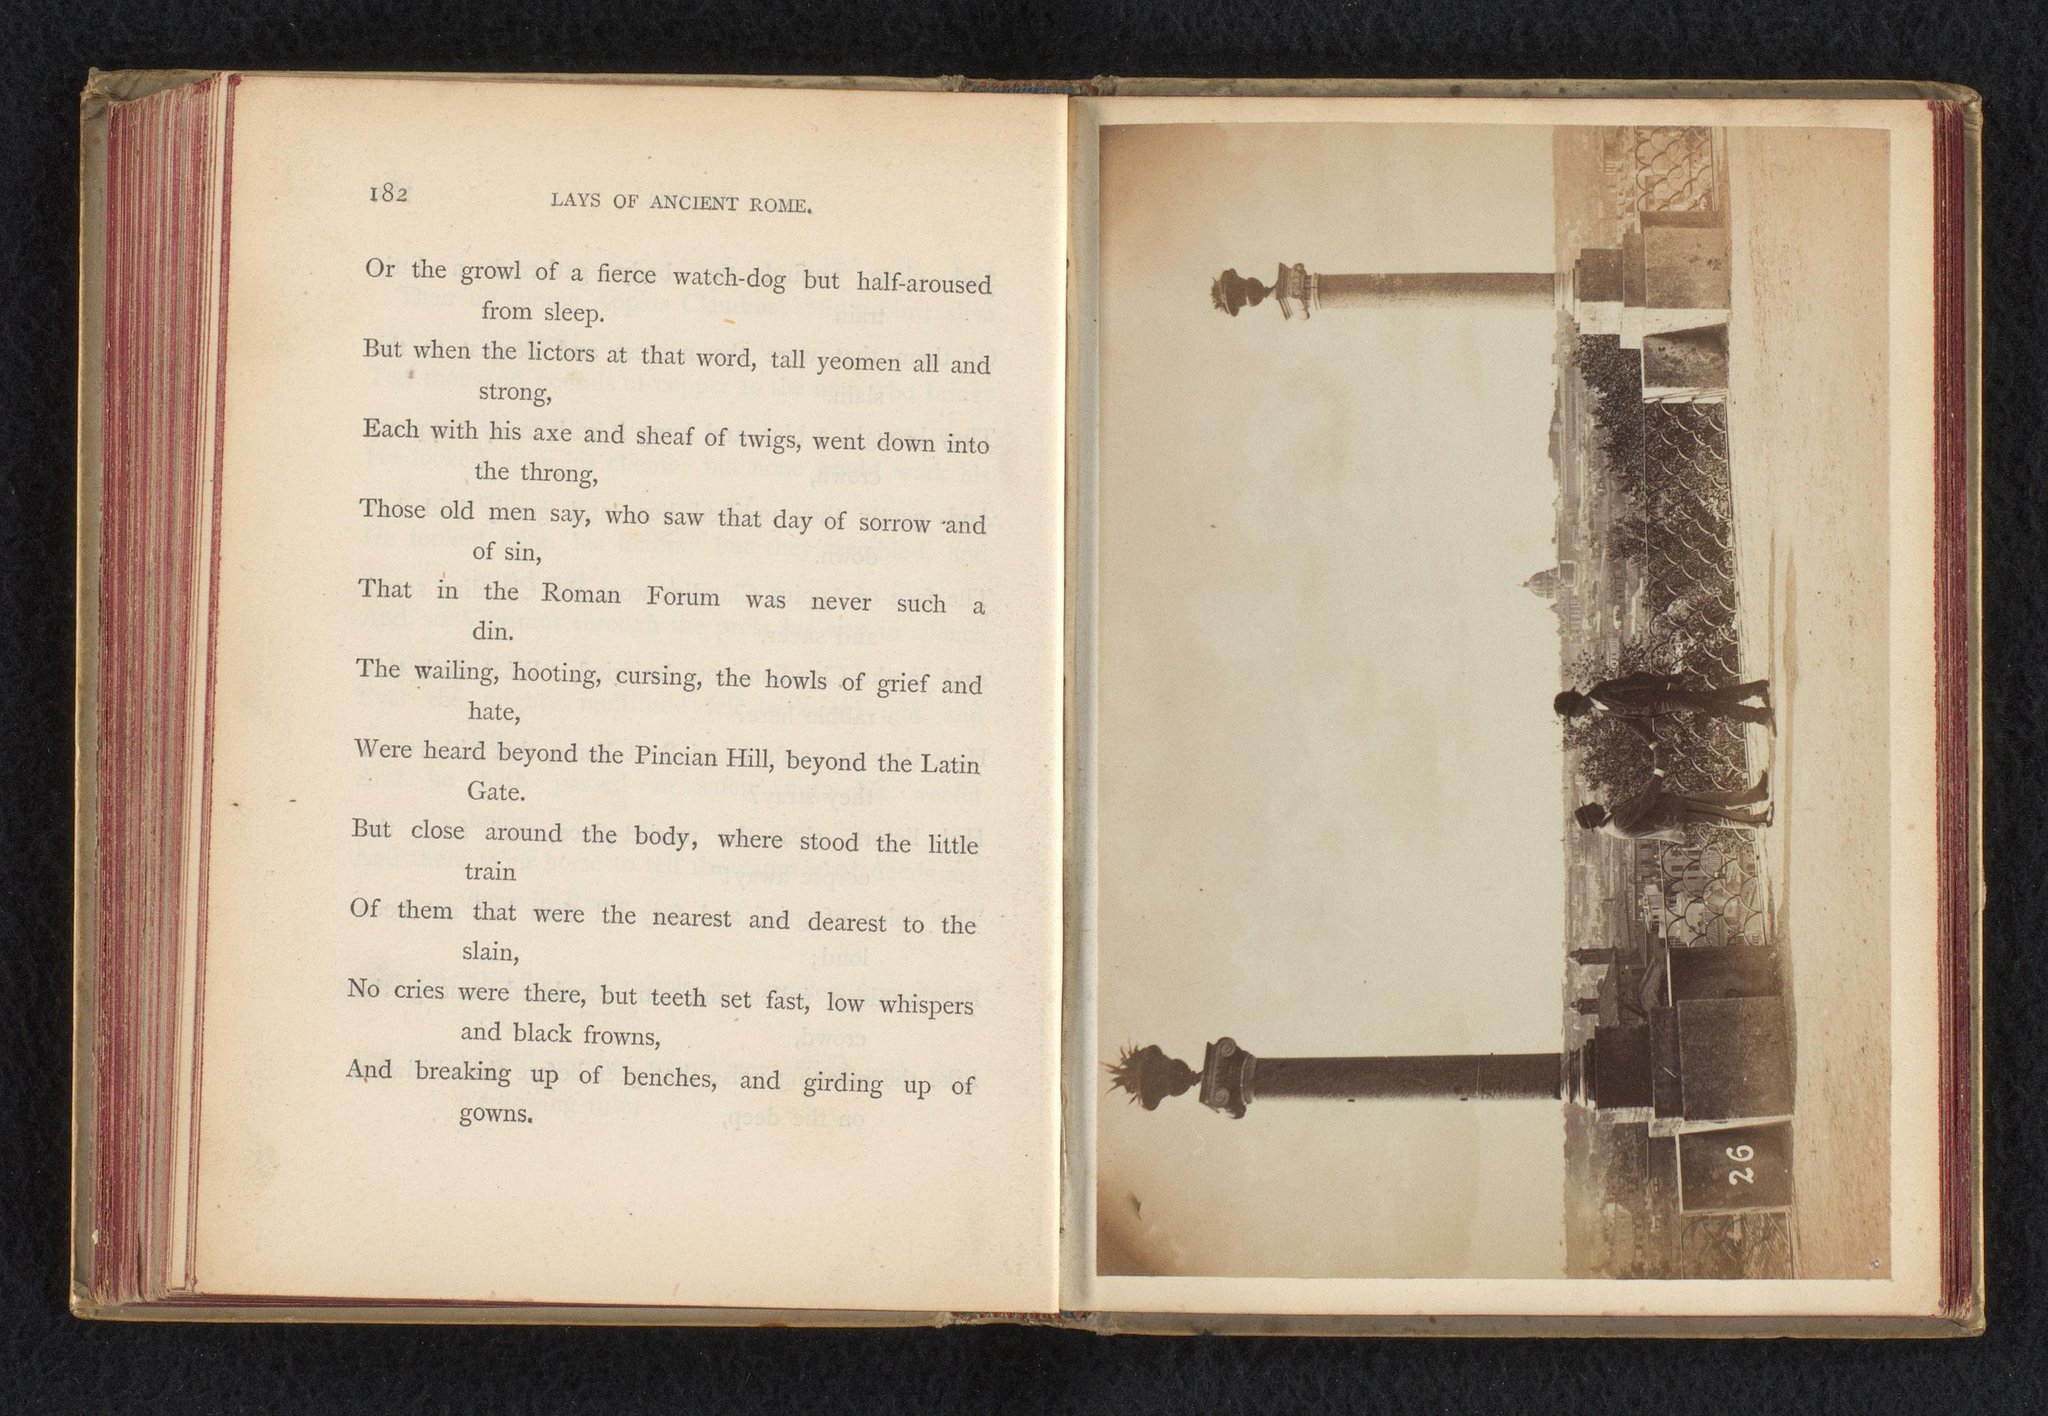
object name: page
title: Twee mannen schudden elkaar de hand op het Terrazza del Pincio, Rome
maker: Anonymous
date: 1851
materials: paper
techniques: albumen print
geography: rome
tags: shaking hands, 'dextrarum junctio', city-view in general; 'veduta'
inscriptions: number: ‘26’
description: Foto op ongenummerde pagina tegenover pagina 182.